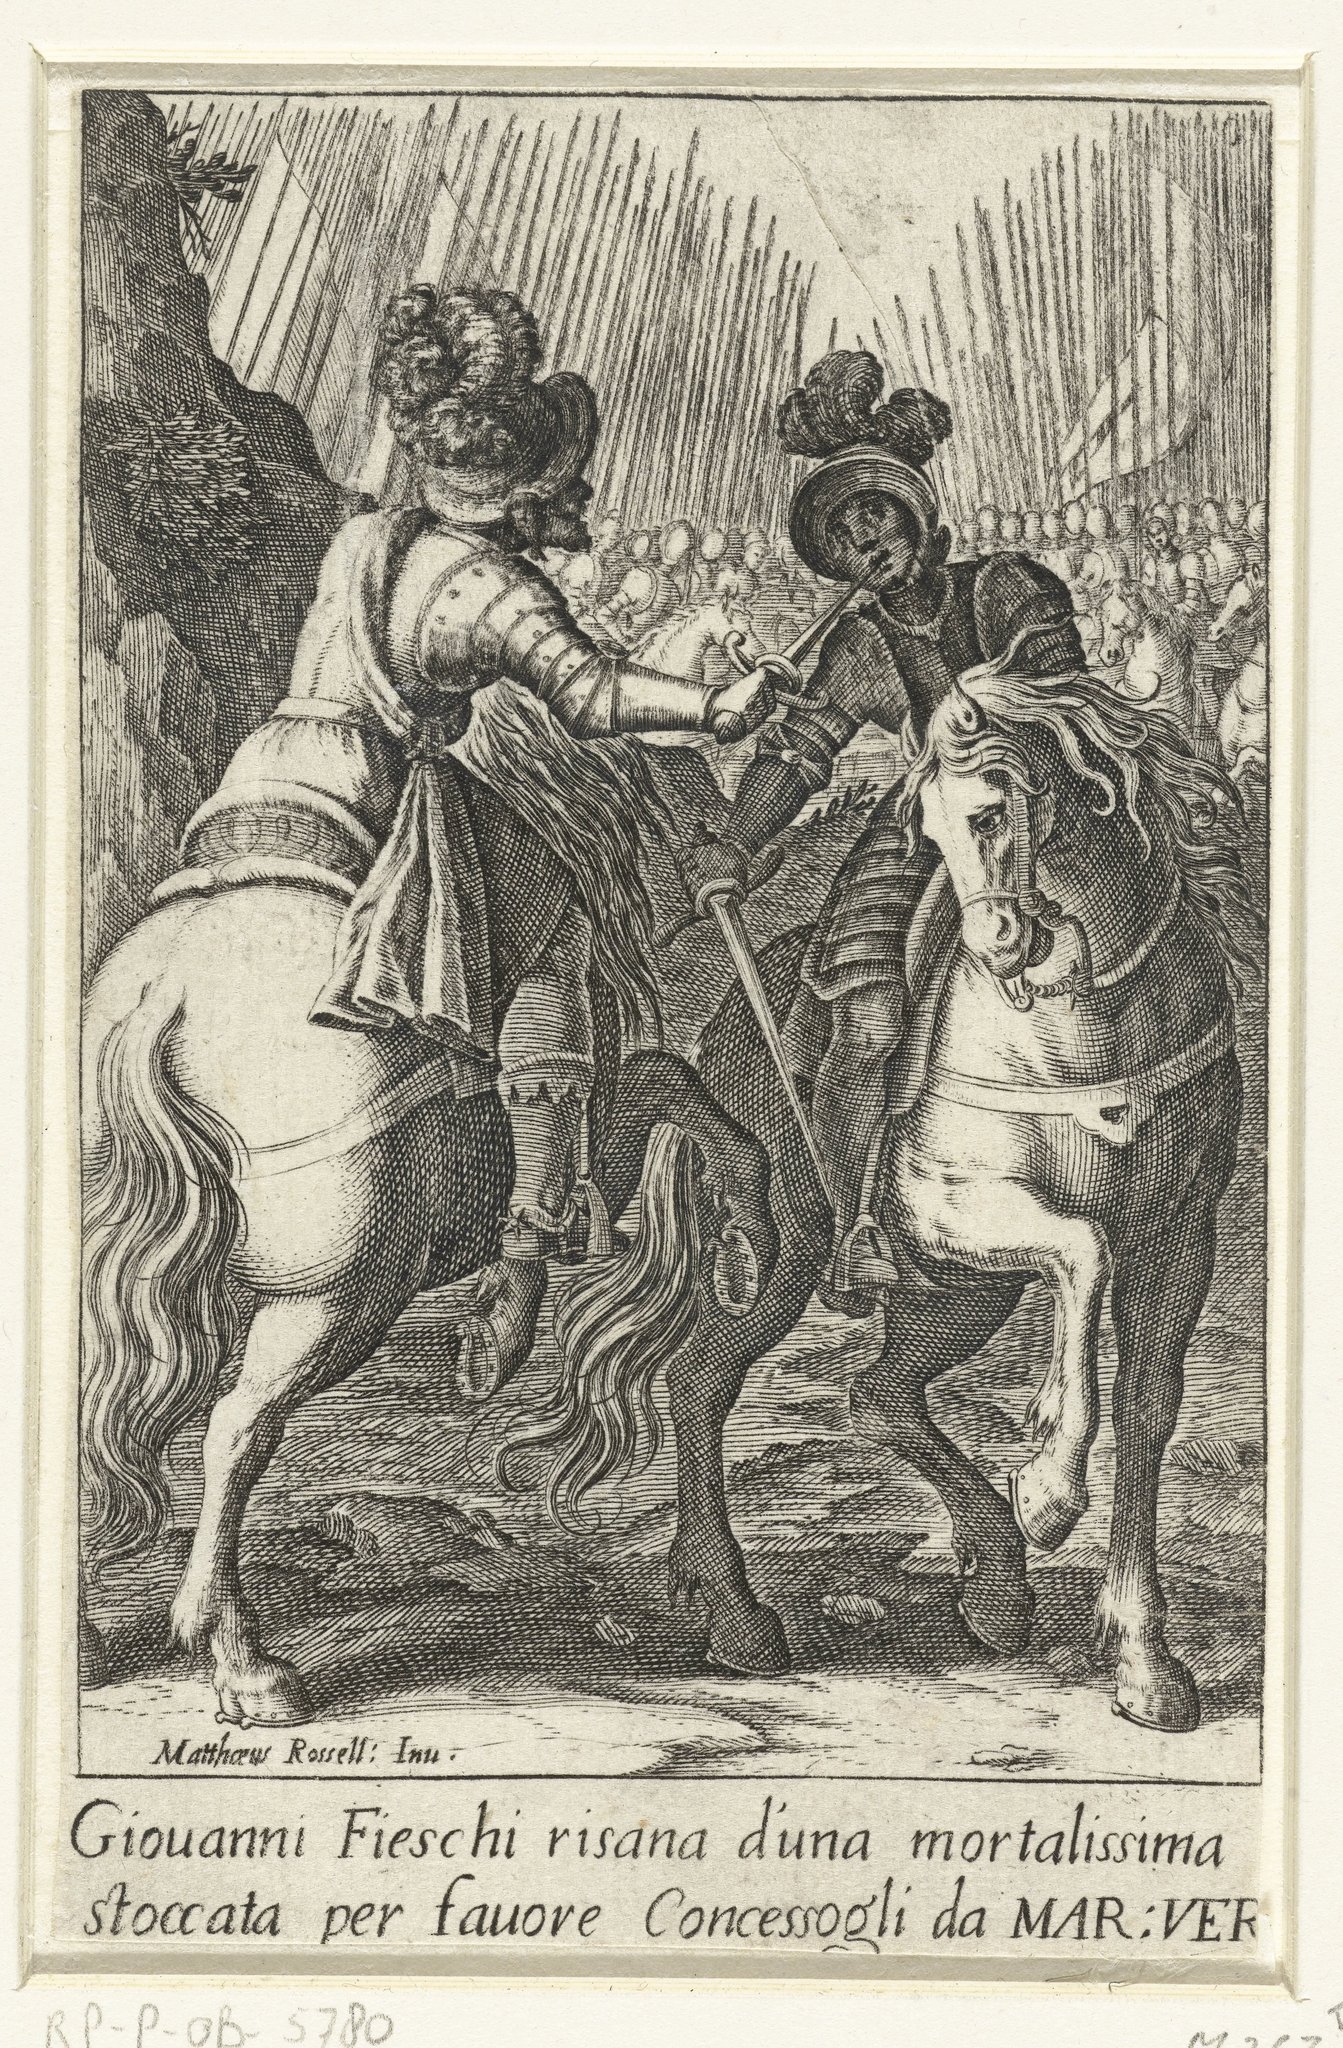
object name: print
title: Het wonder van Giovanni Fieschi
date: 1614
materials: paper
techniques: engraving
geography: florence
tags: hacking and thrusting weapons: sword, warfare; military affairs (+ cavalry, horsemen)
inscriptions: collector's mark: Lugt 240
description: Een ruiter wordt door een andere ruiter met een zwaard in het gezicht gestoken. Op de achtergrond een troep speerruiters. Onder de voorstelling twee regels Latijnse tekst.